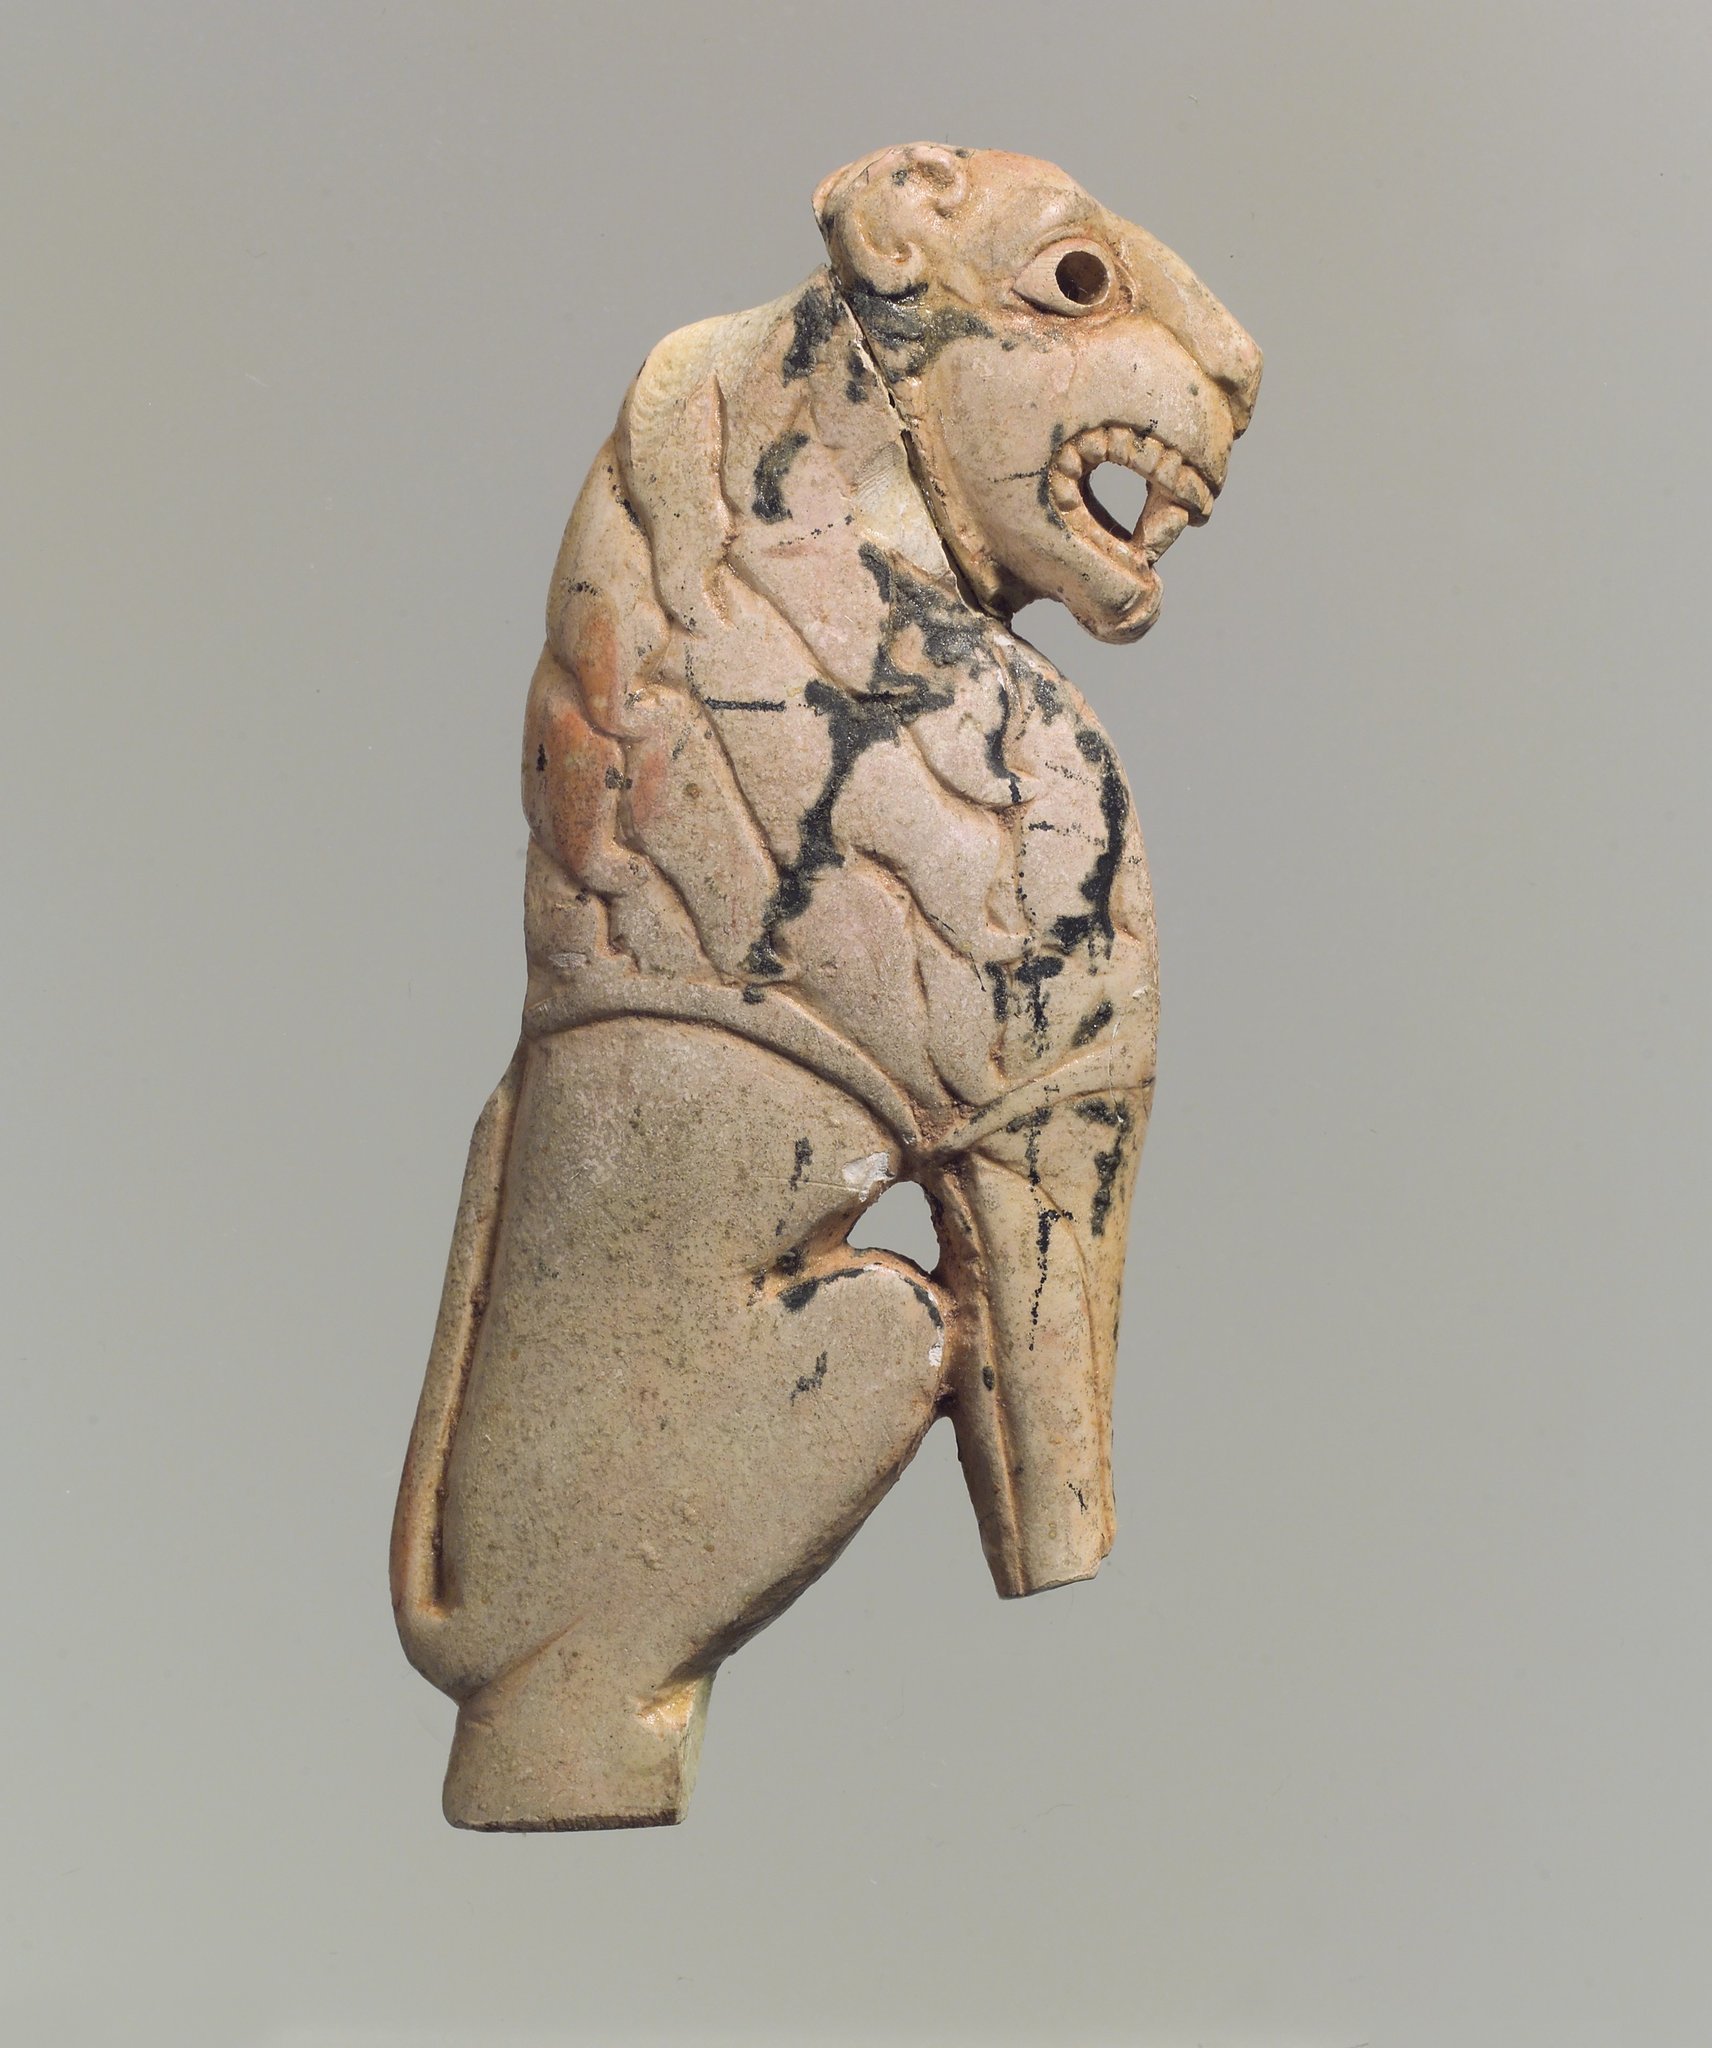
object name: furniture element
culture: assyrian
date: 1800-1701 BCE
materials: ivory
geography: anatolia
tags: animals